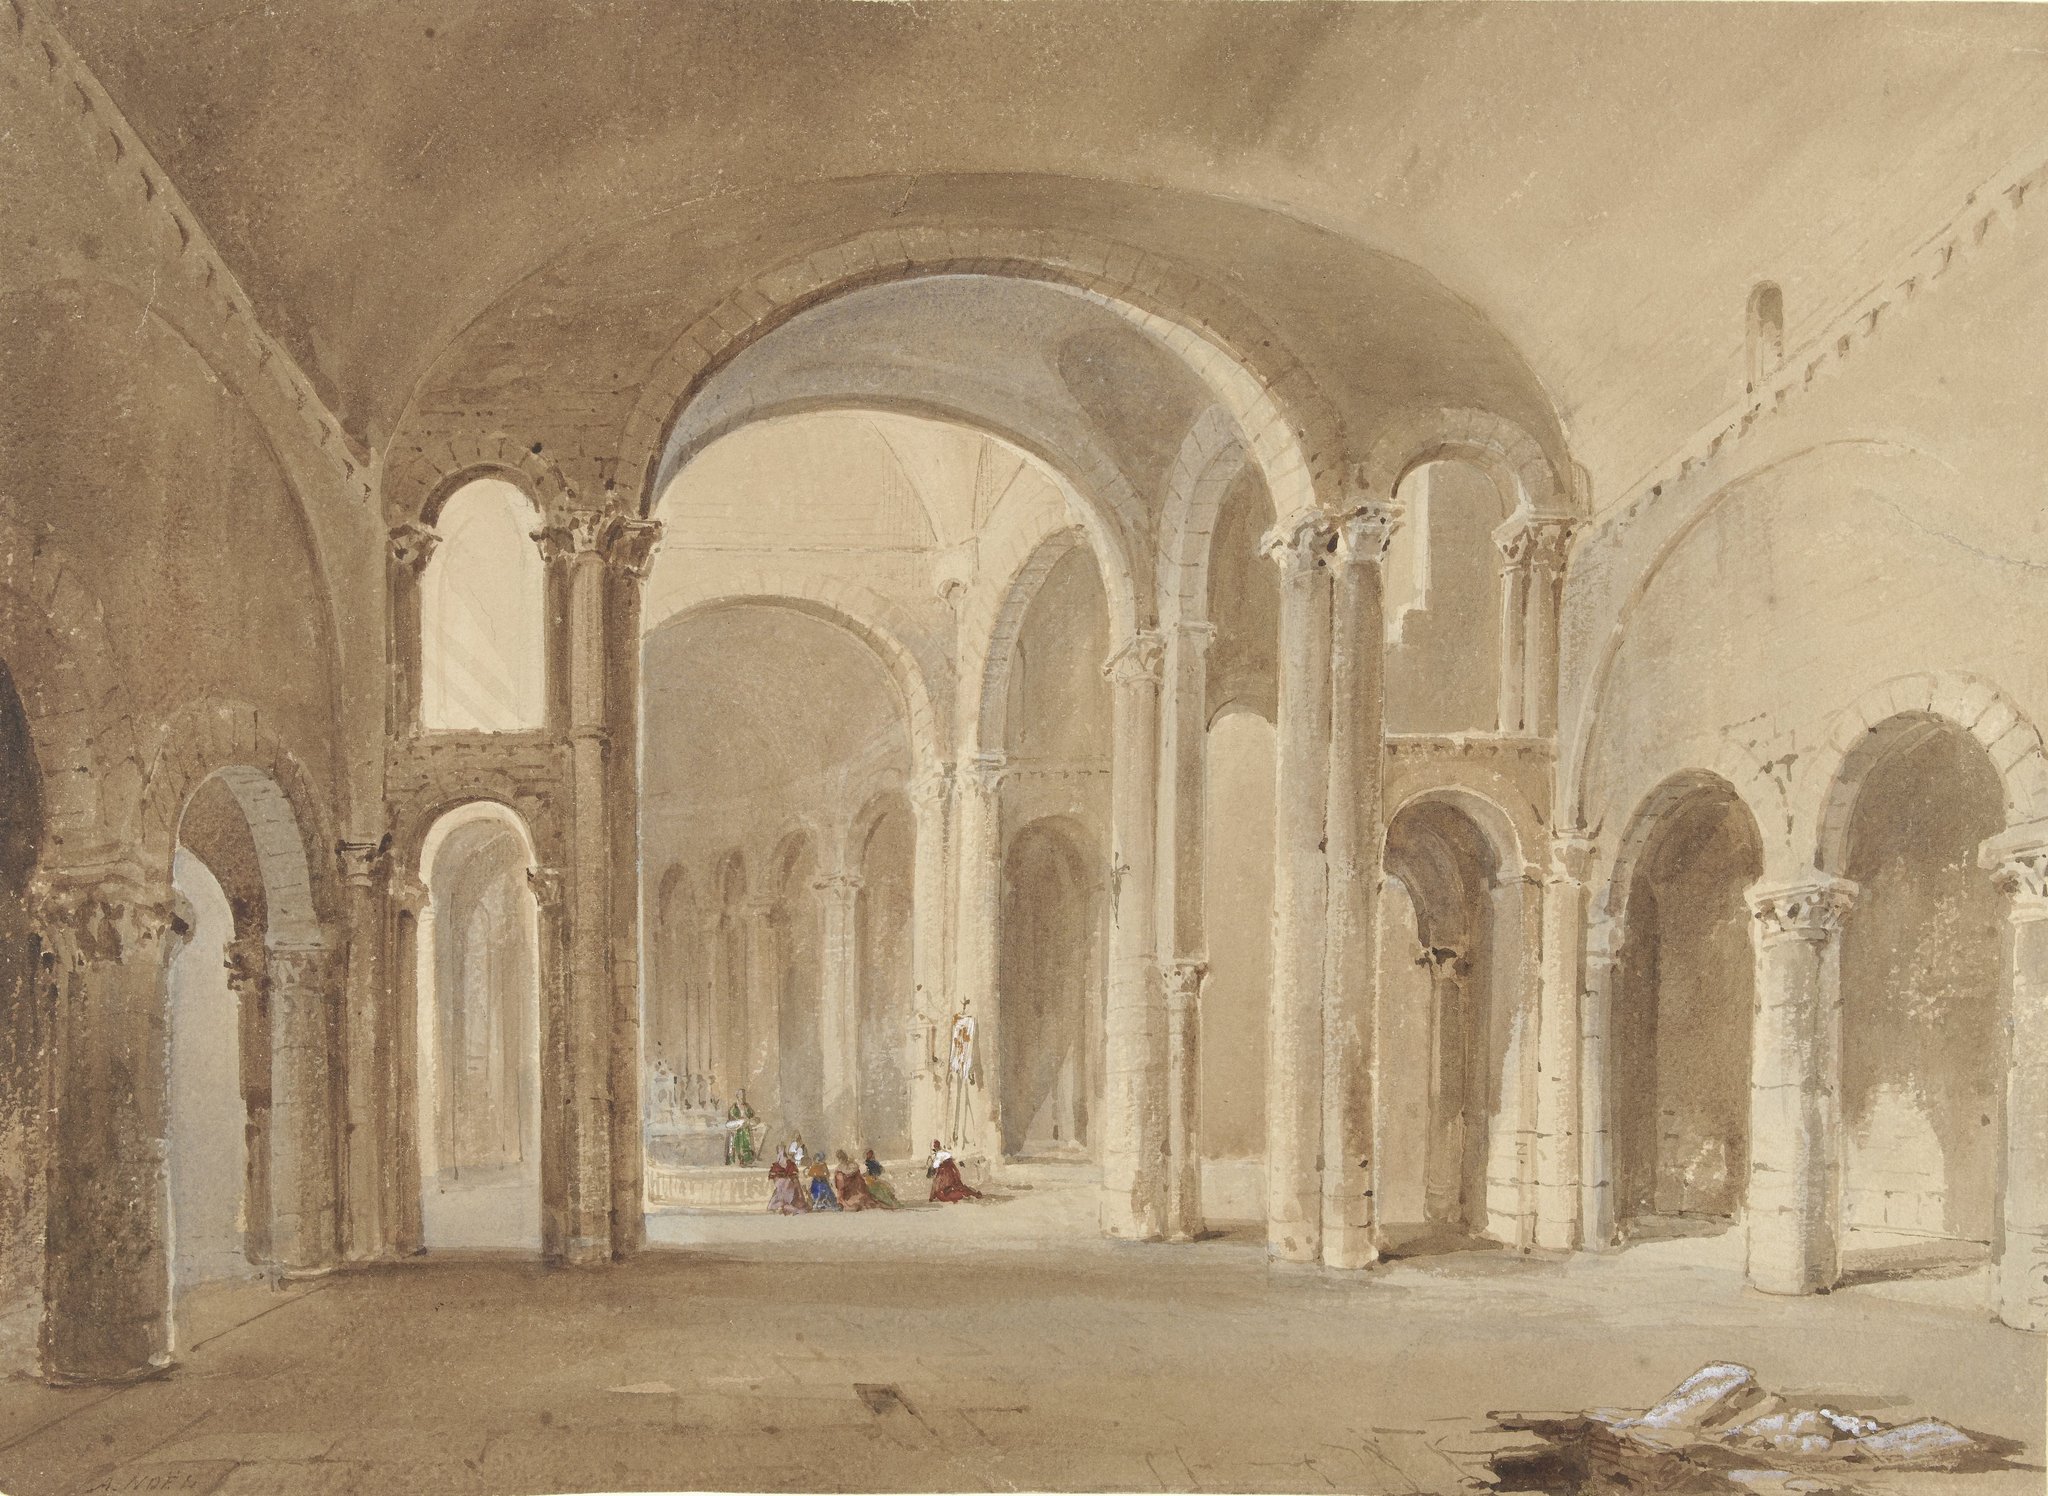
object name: drawing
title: Interieur van S. Hilaire te Poitiers, met knielende figuren aan de Confessio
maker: alexis nicolas noël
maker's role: draughtsman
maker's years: 1792-1871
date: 1802-1871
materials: paper, watercolor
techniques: brush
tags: interior of church